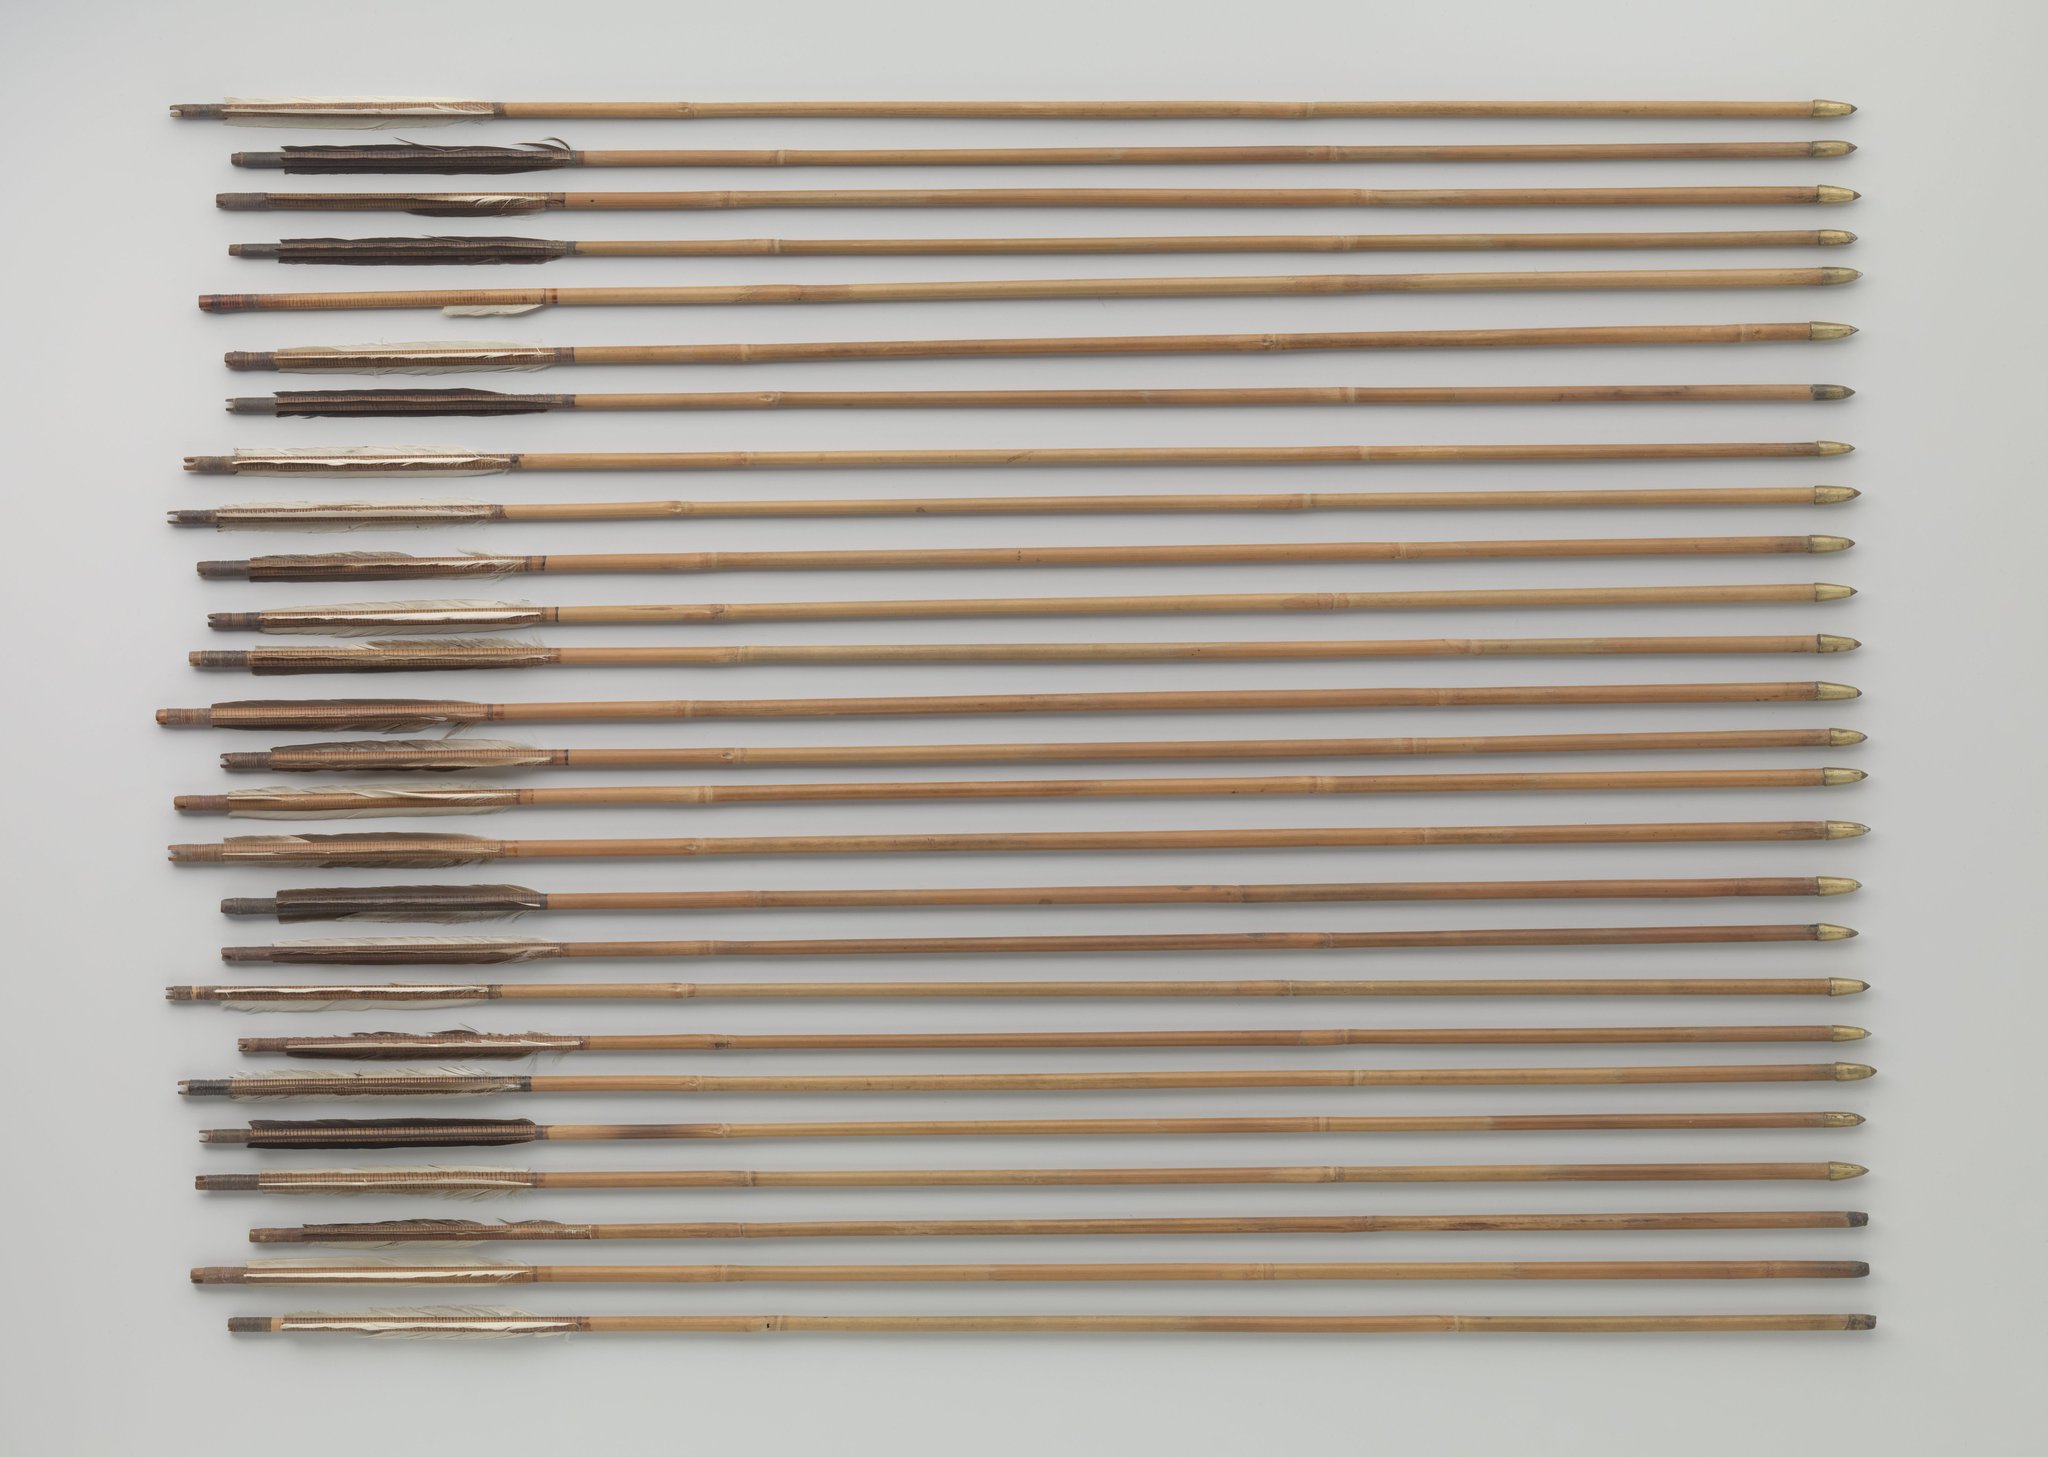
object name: arrow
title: 26 Pijlen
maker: Anonymous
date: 1650-1679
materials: feather, wood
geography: southeast asia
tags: rotterdam, amsterdam, cornelis tromp, flowers ~ ornament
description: 26 Pijlen uit houten pijlkoker van Cornelis Tromp.